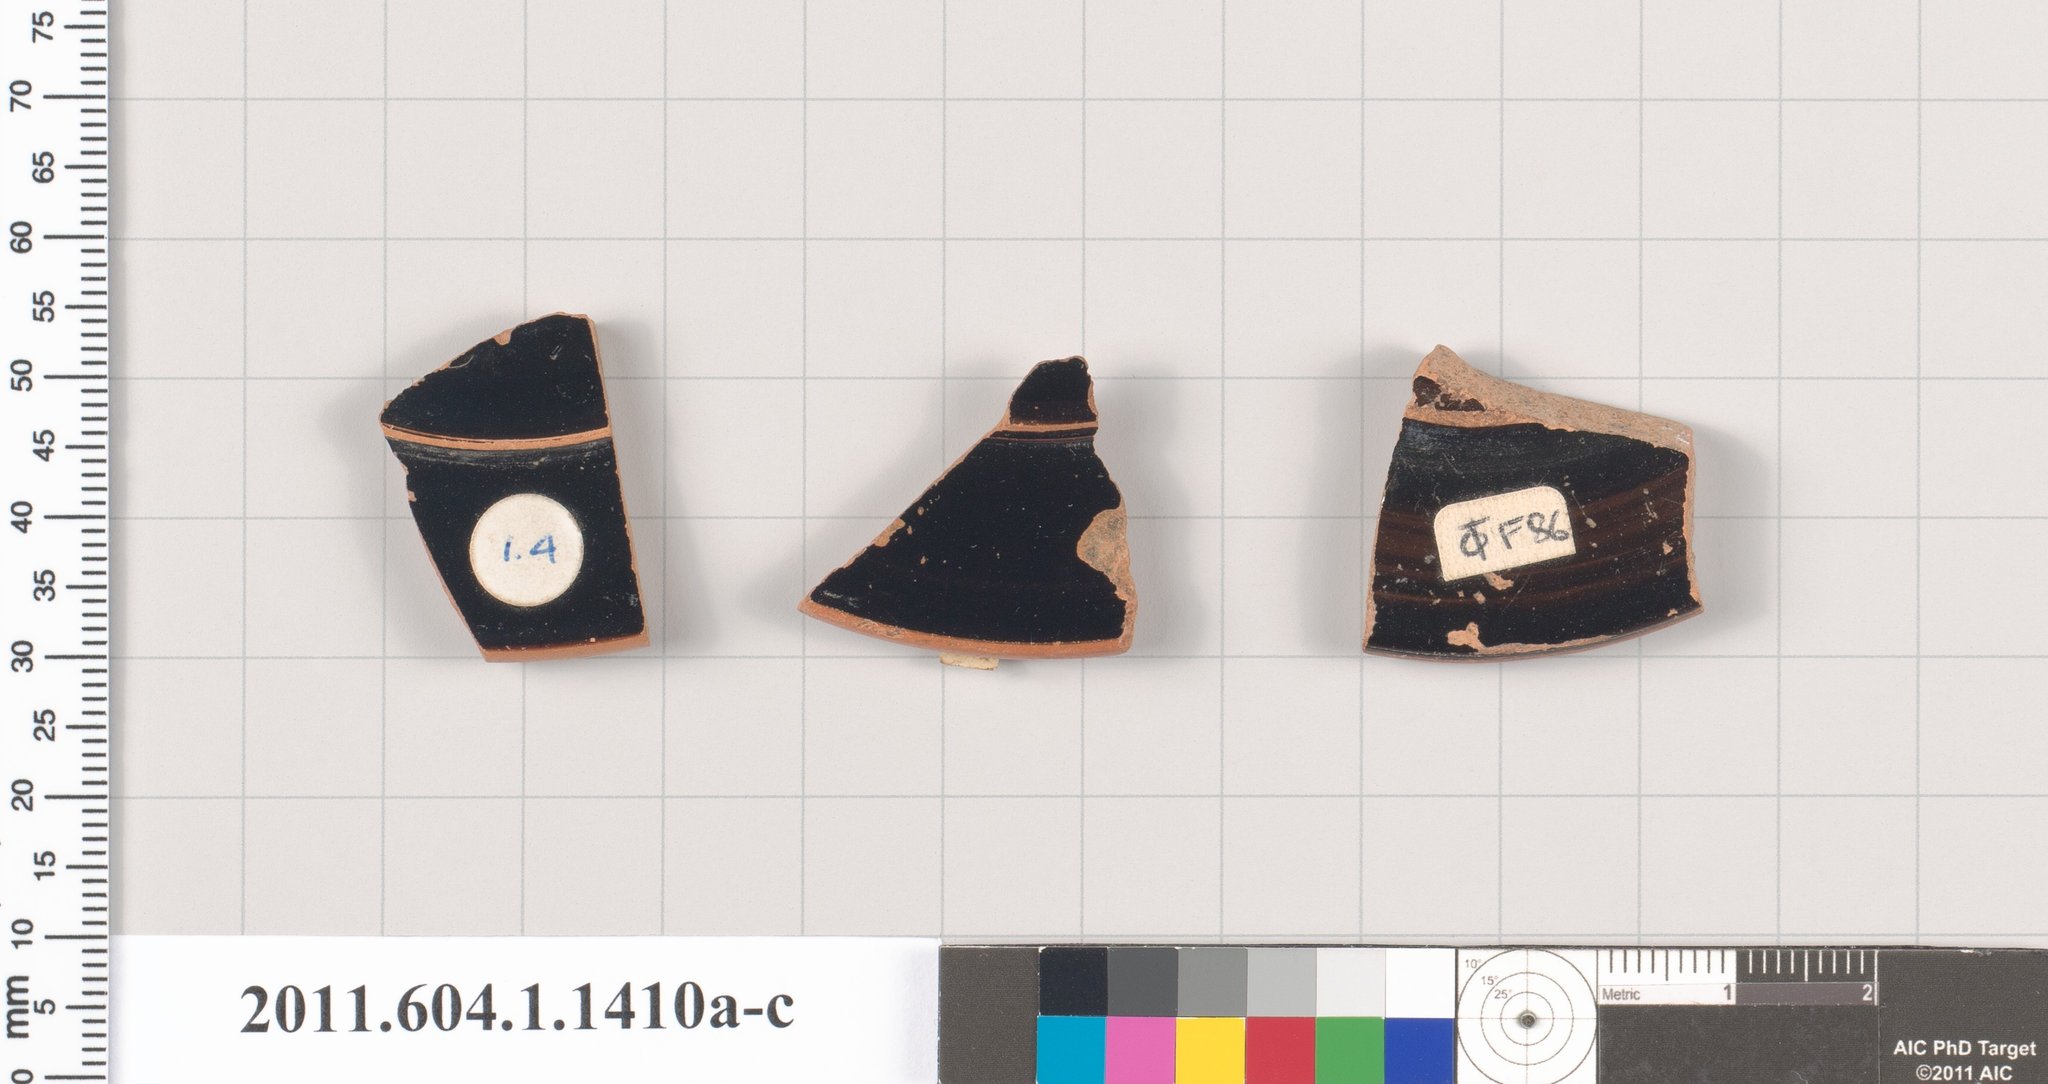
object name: kylix fragment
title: Terracotta fragments of kylikes (drinking cups)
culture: greek, attic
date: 500-401 BCE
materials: terracotta